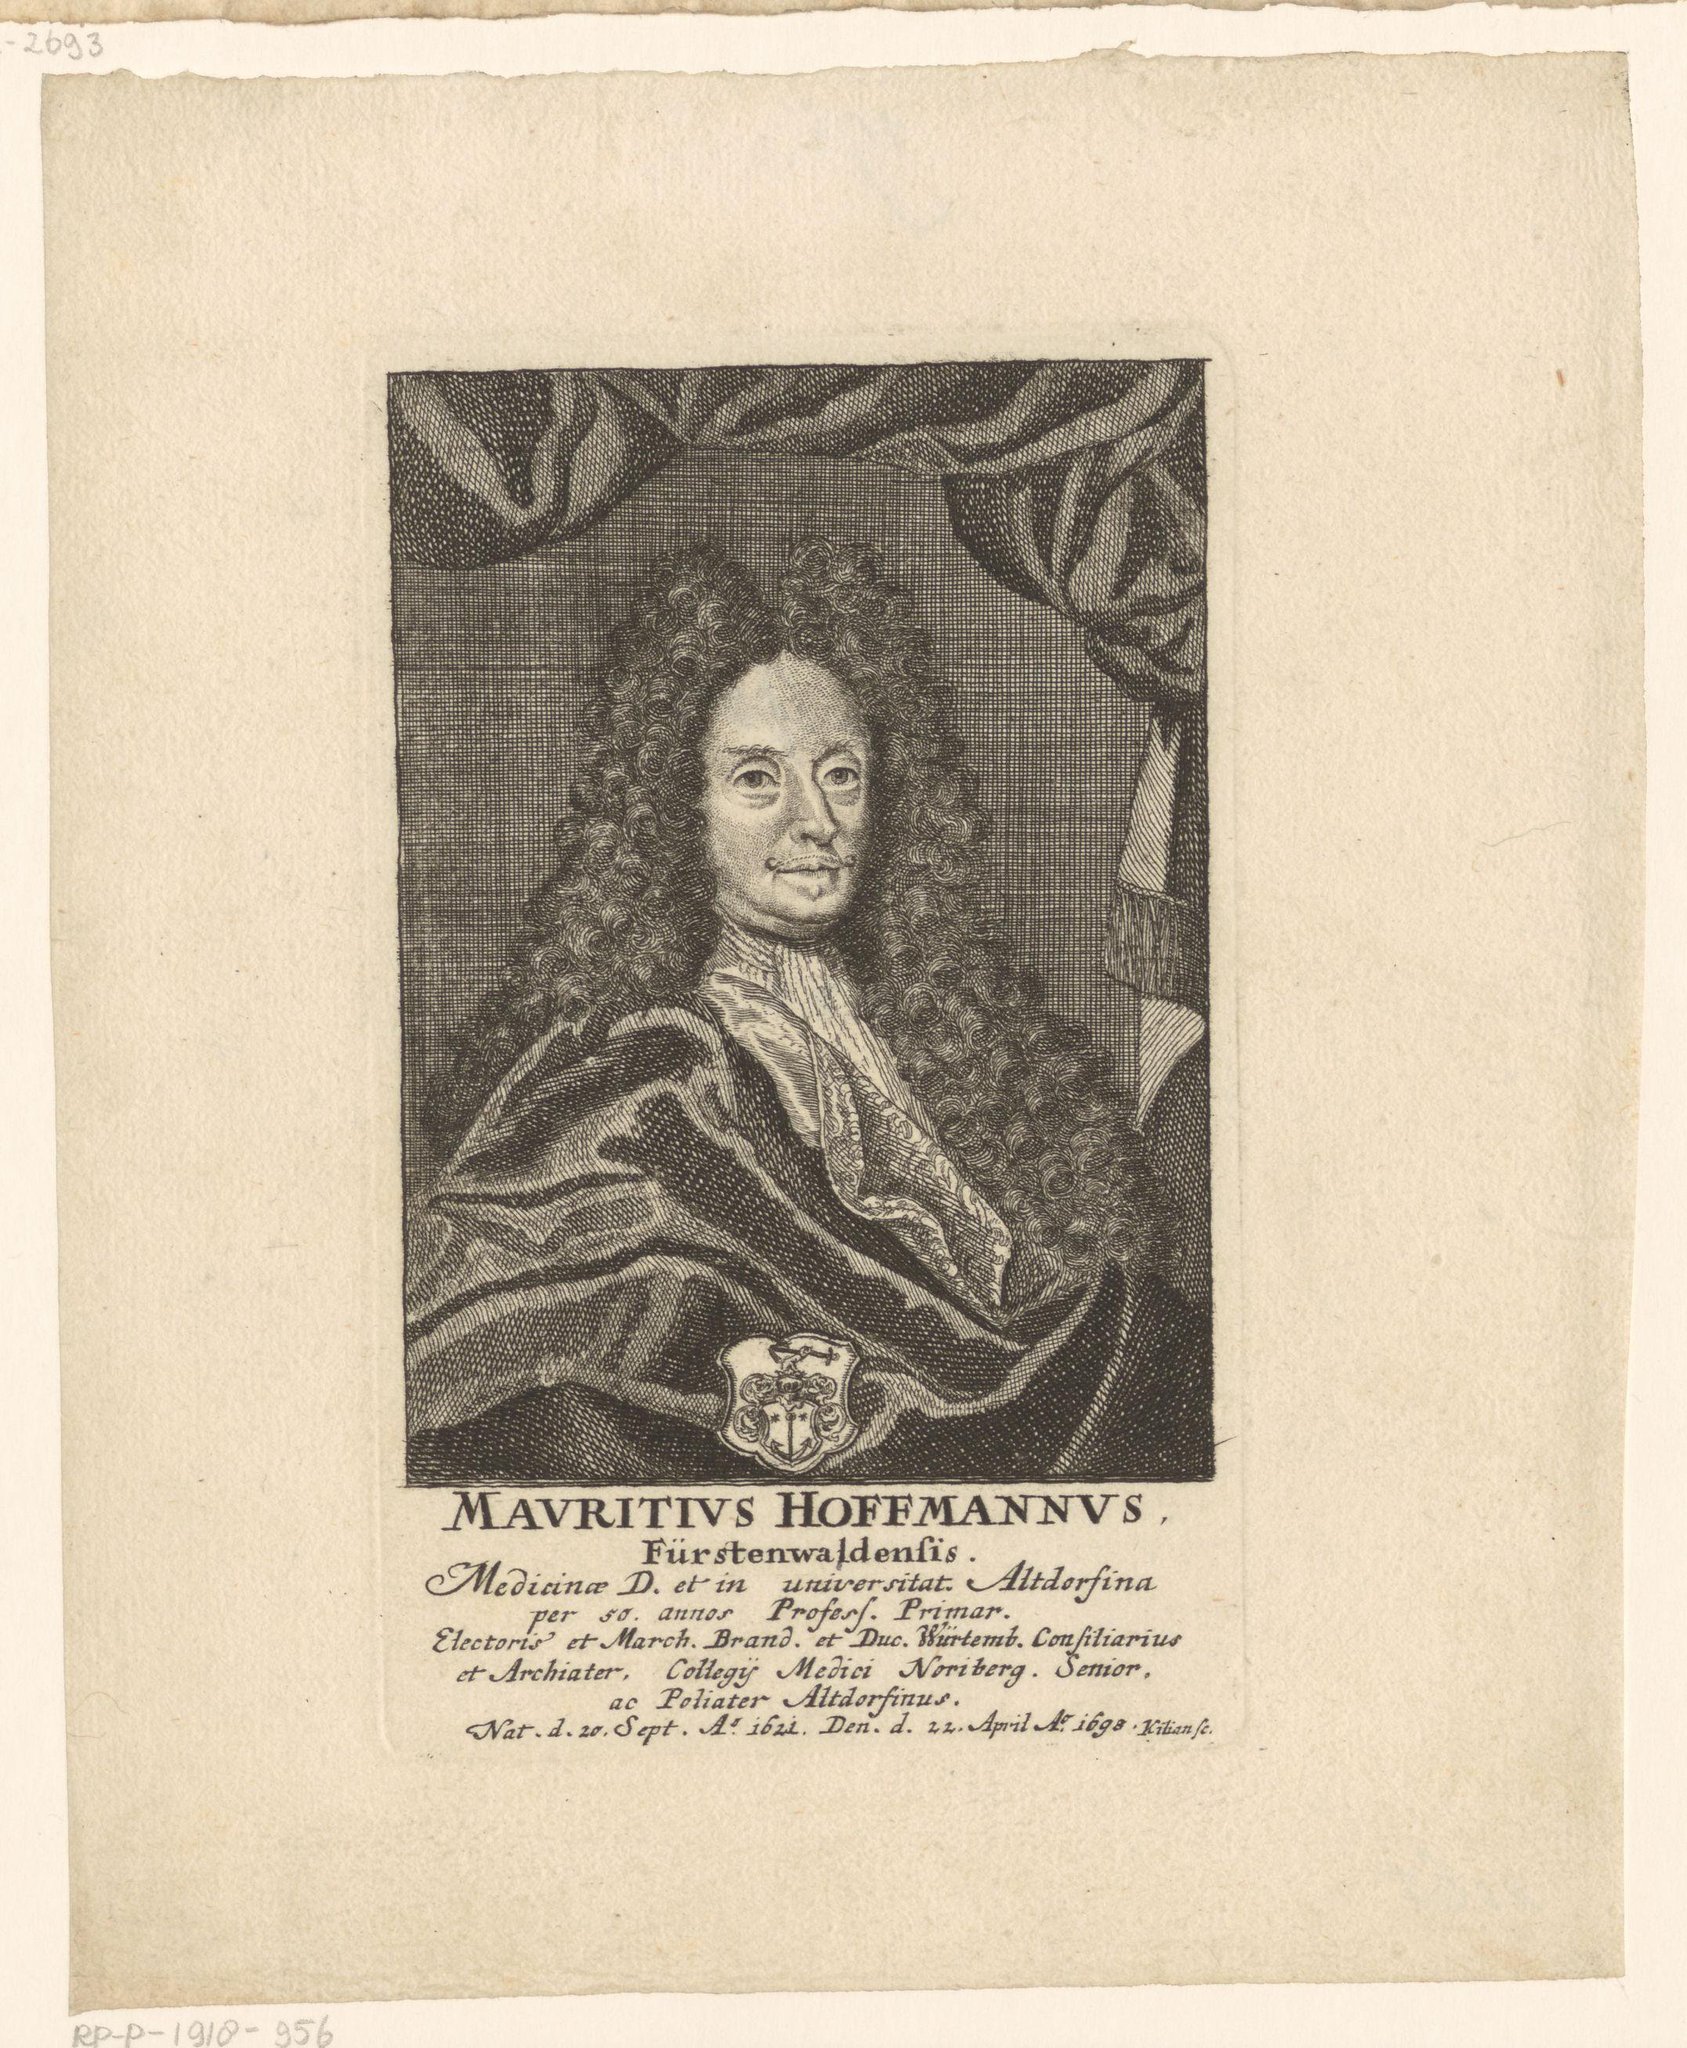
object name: print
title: Portret van Moritz Hoffmann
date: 1698-1732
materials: paper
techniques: engraving, etching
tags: further education (+ portrait of teacher, professor), historical persons, physician, doctor (+ portrait of scholar, scientist)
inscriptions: collector's mark: Lugt 2233